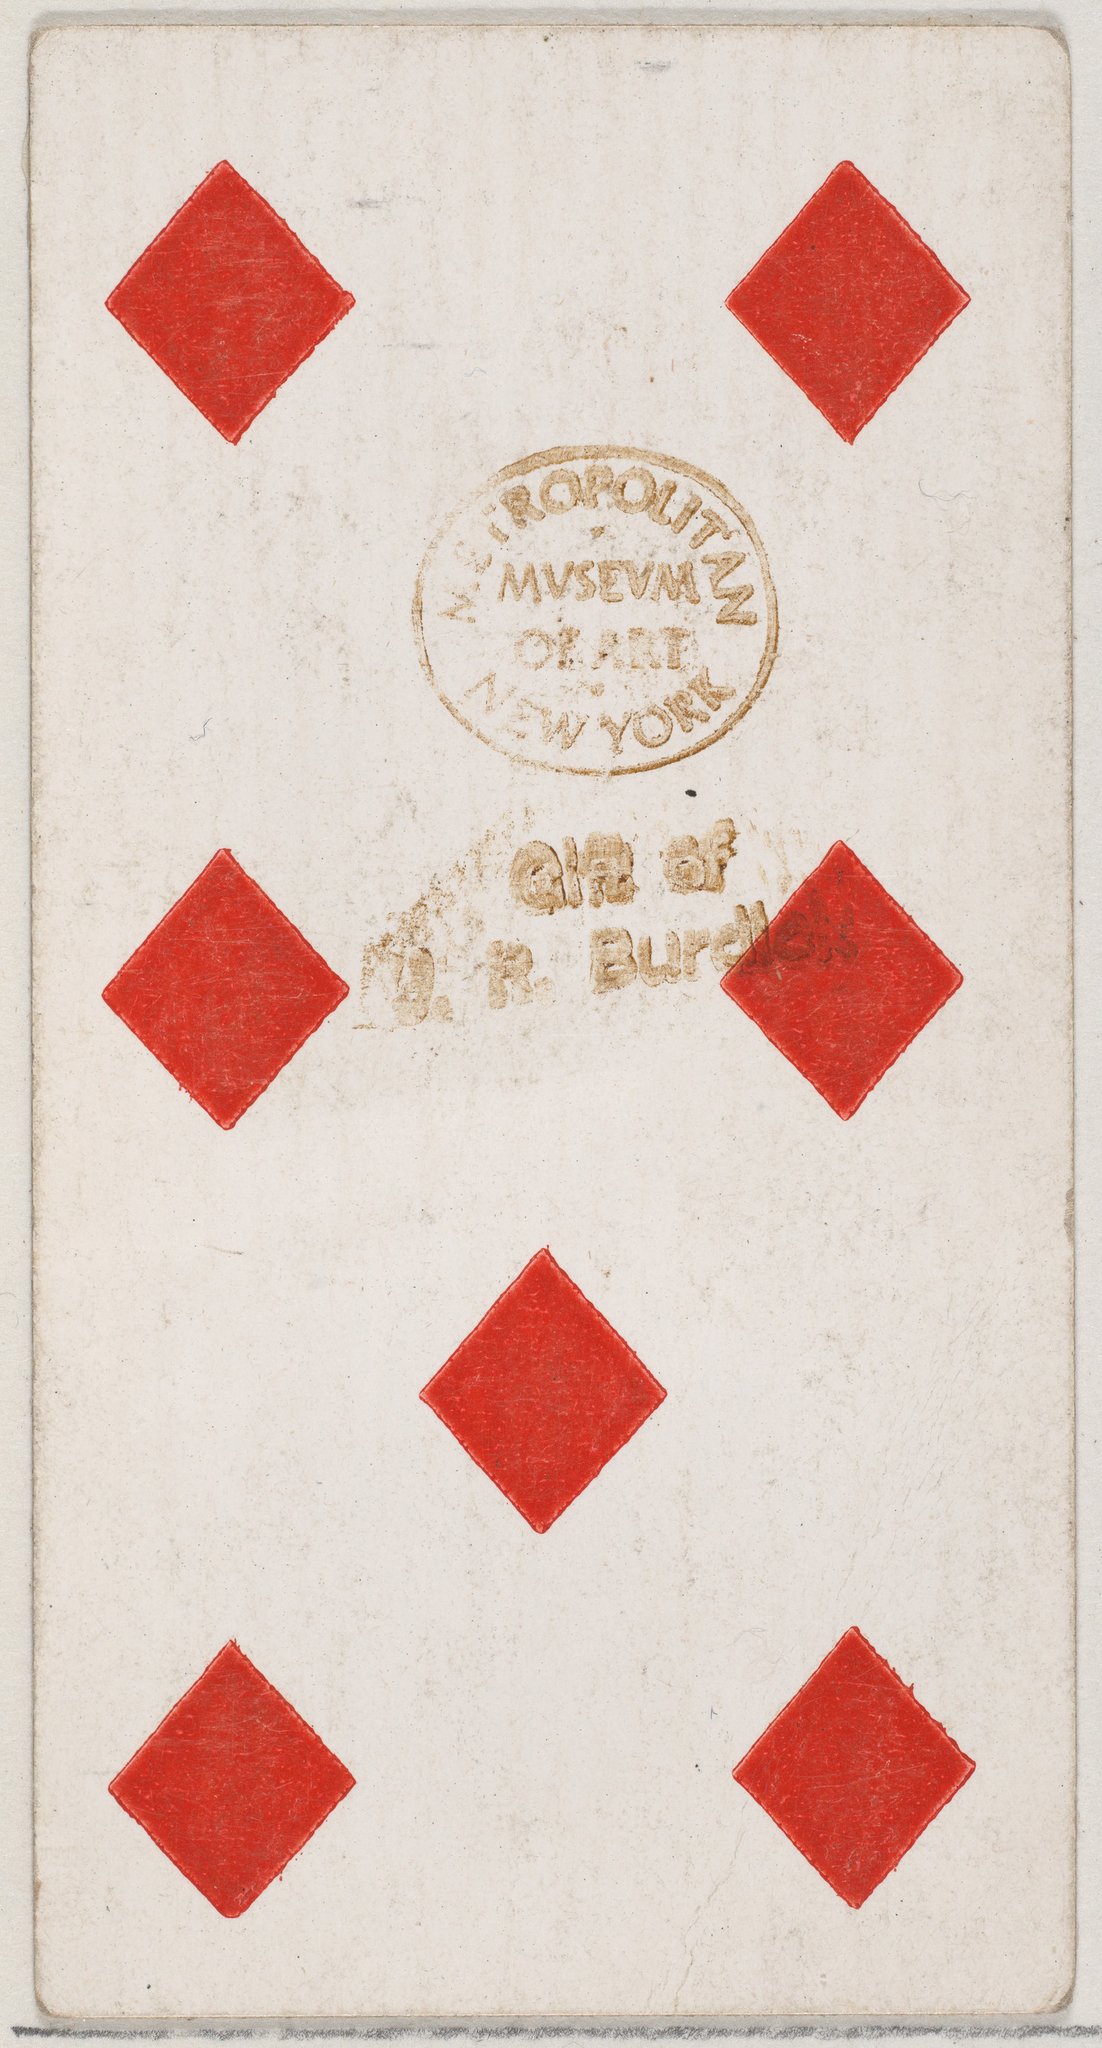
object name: print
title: Seven Diamonds, from the Playing Cards series (N84) to promote Turkish Cross-Cut Cigarettes for W. Duke, Sons and Co.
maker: w. duke, sons & co.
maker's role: publisher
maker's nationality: american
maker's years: 1870-1920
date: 1888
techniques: color lithograph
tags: playing cards